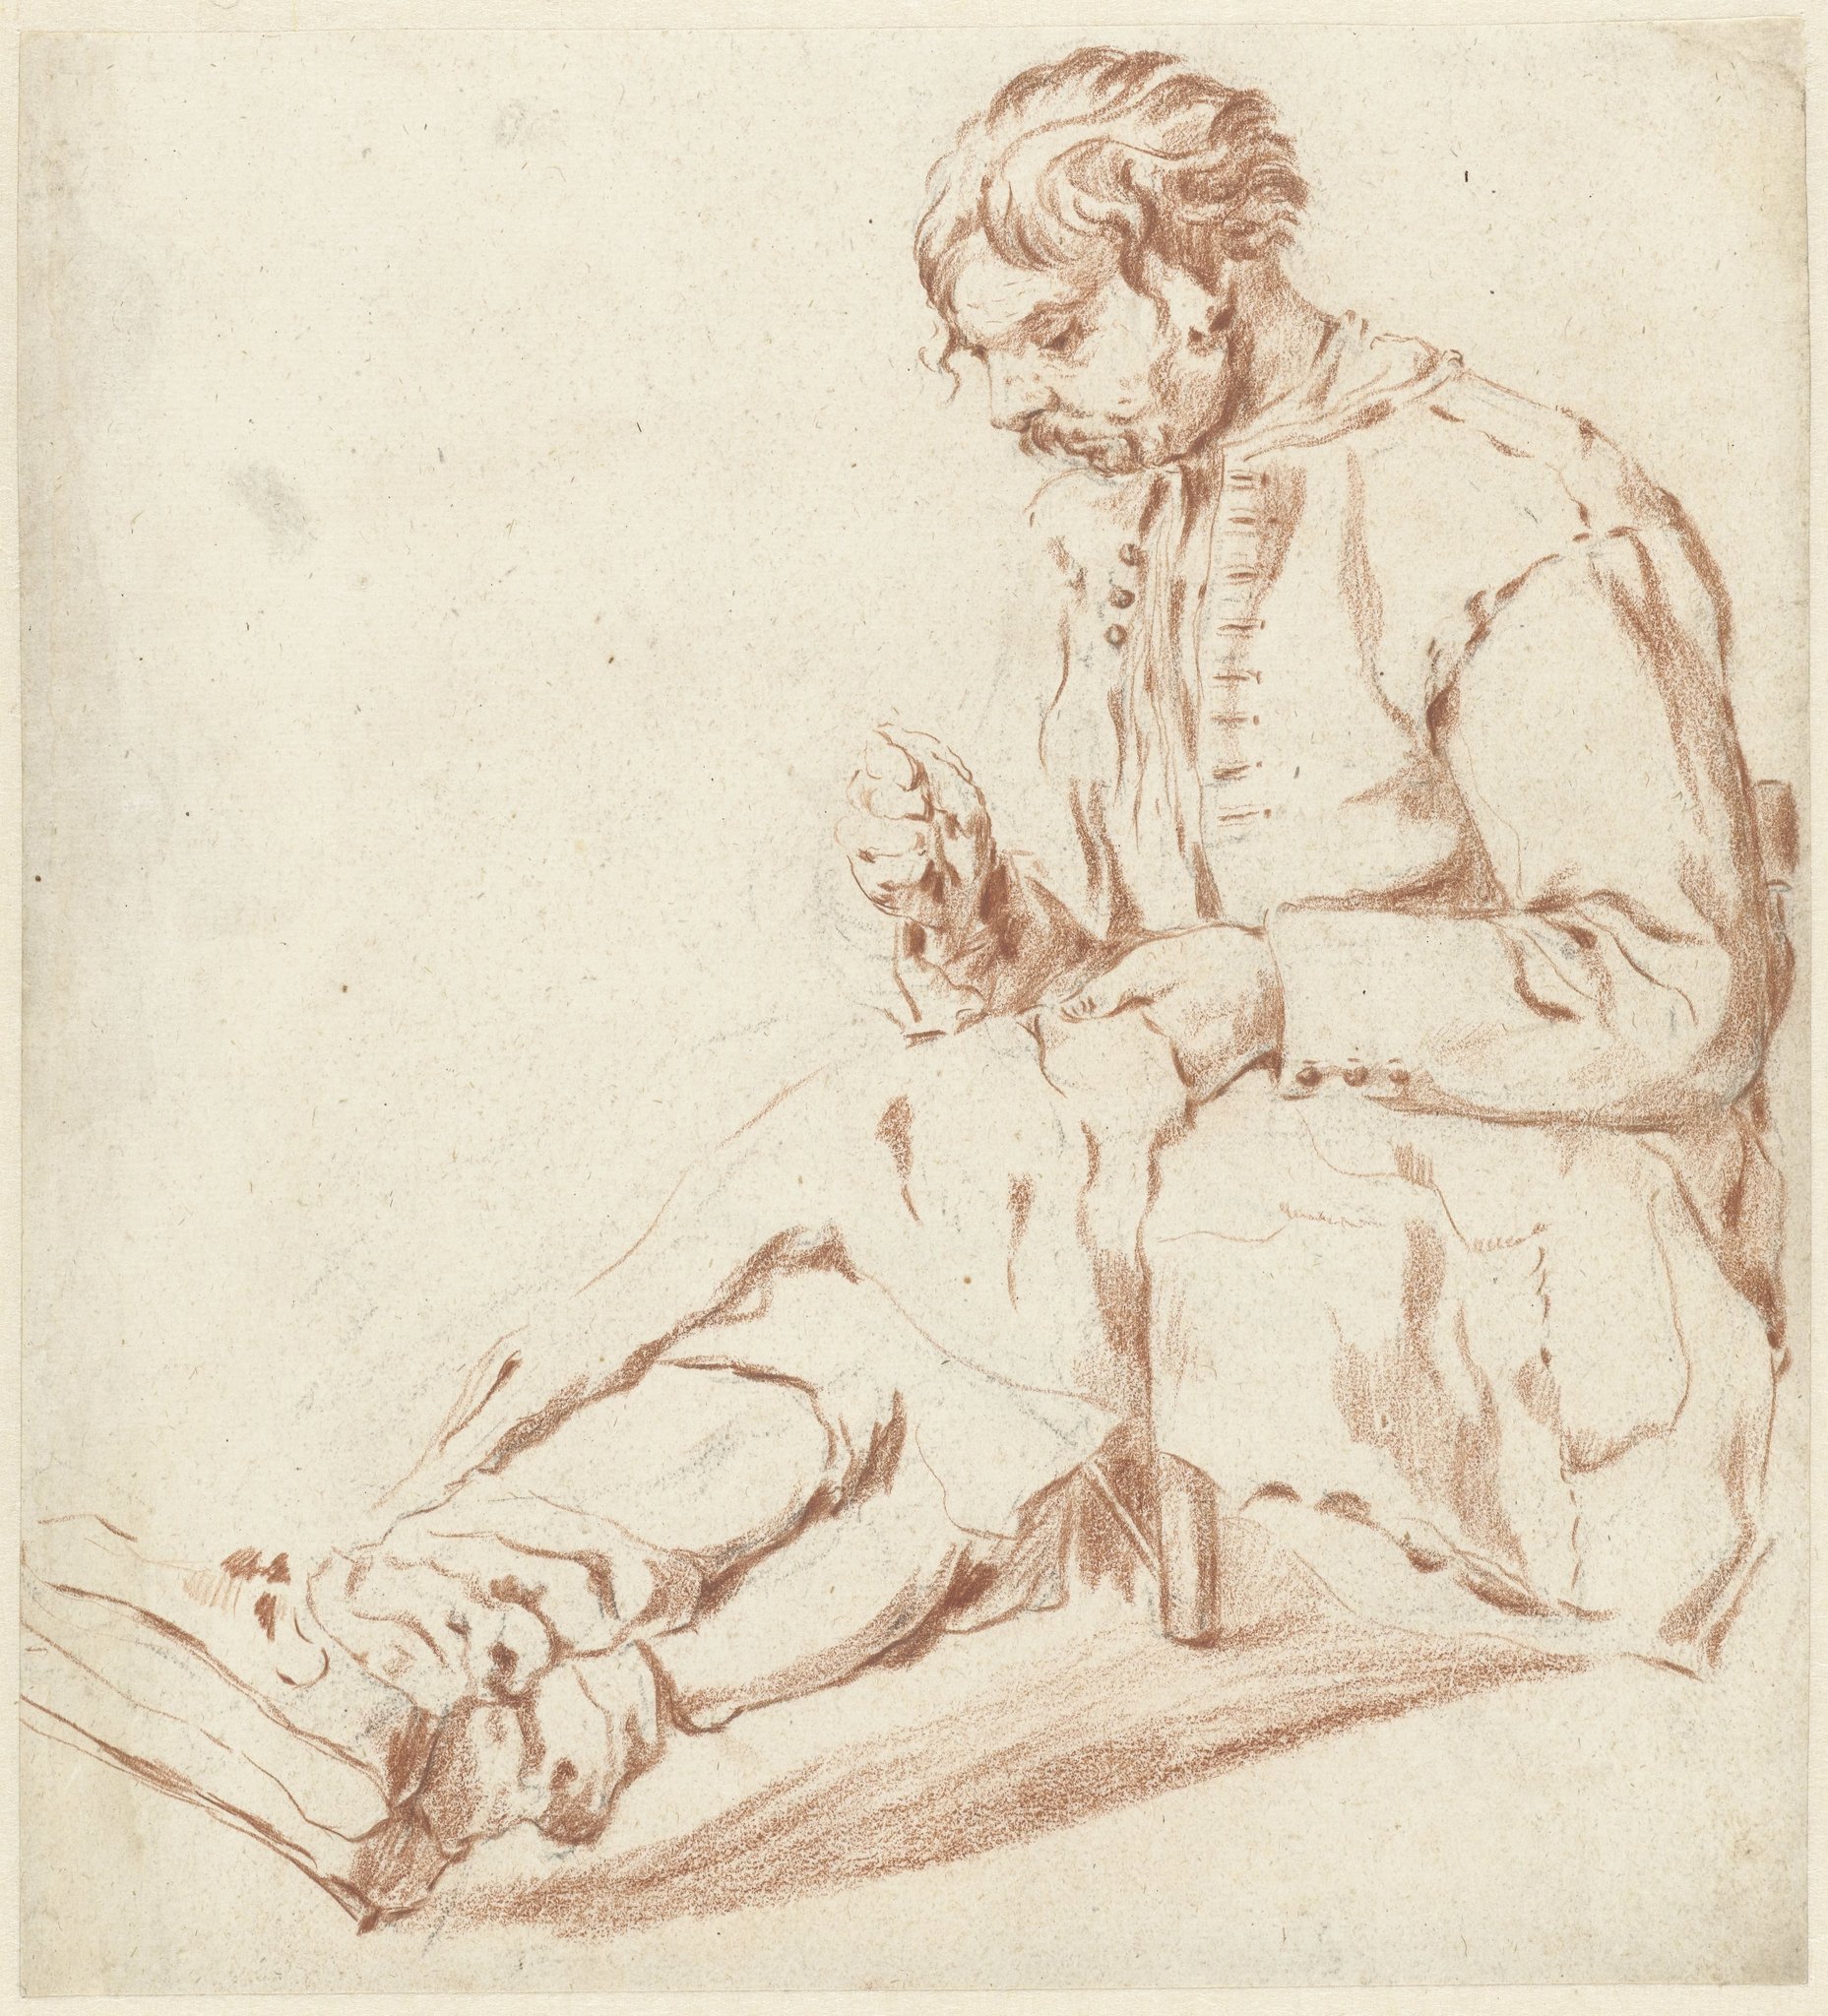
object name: drawing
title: Zittende kleermaker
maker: Anonymous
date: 1700-1800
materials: chalk, paper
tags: tailor, dressmaker